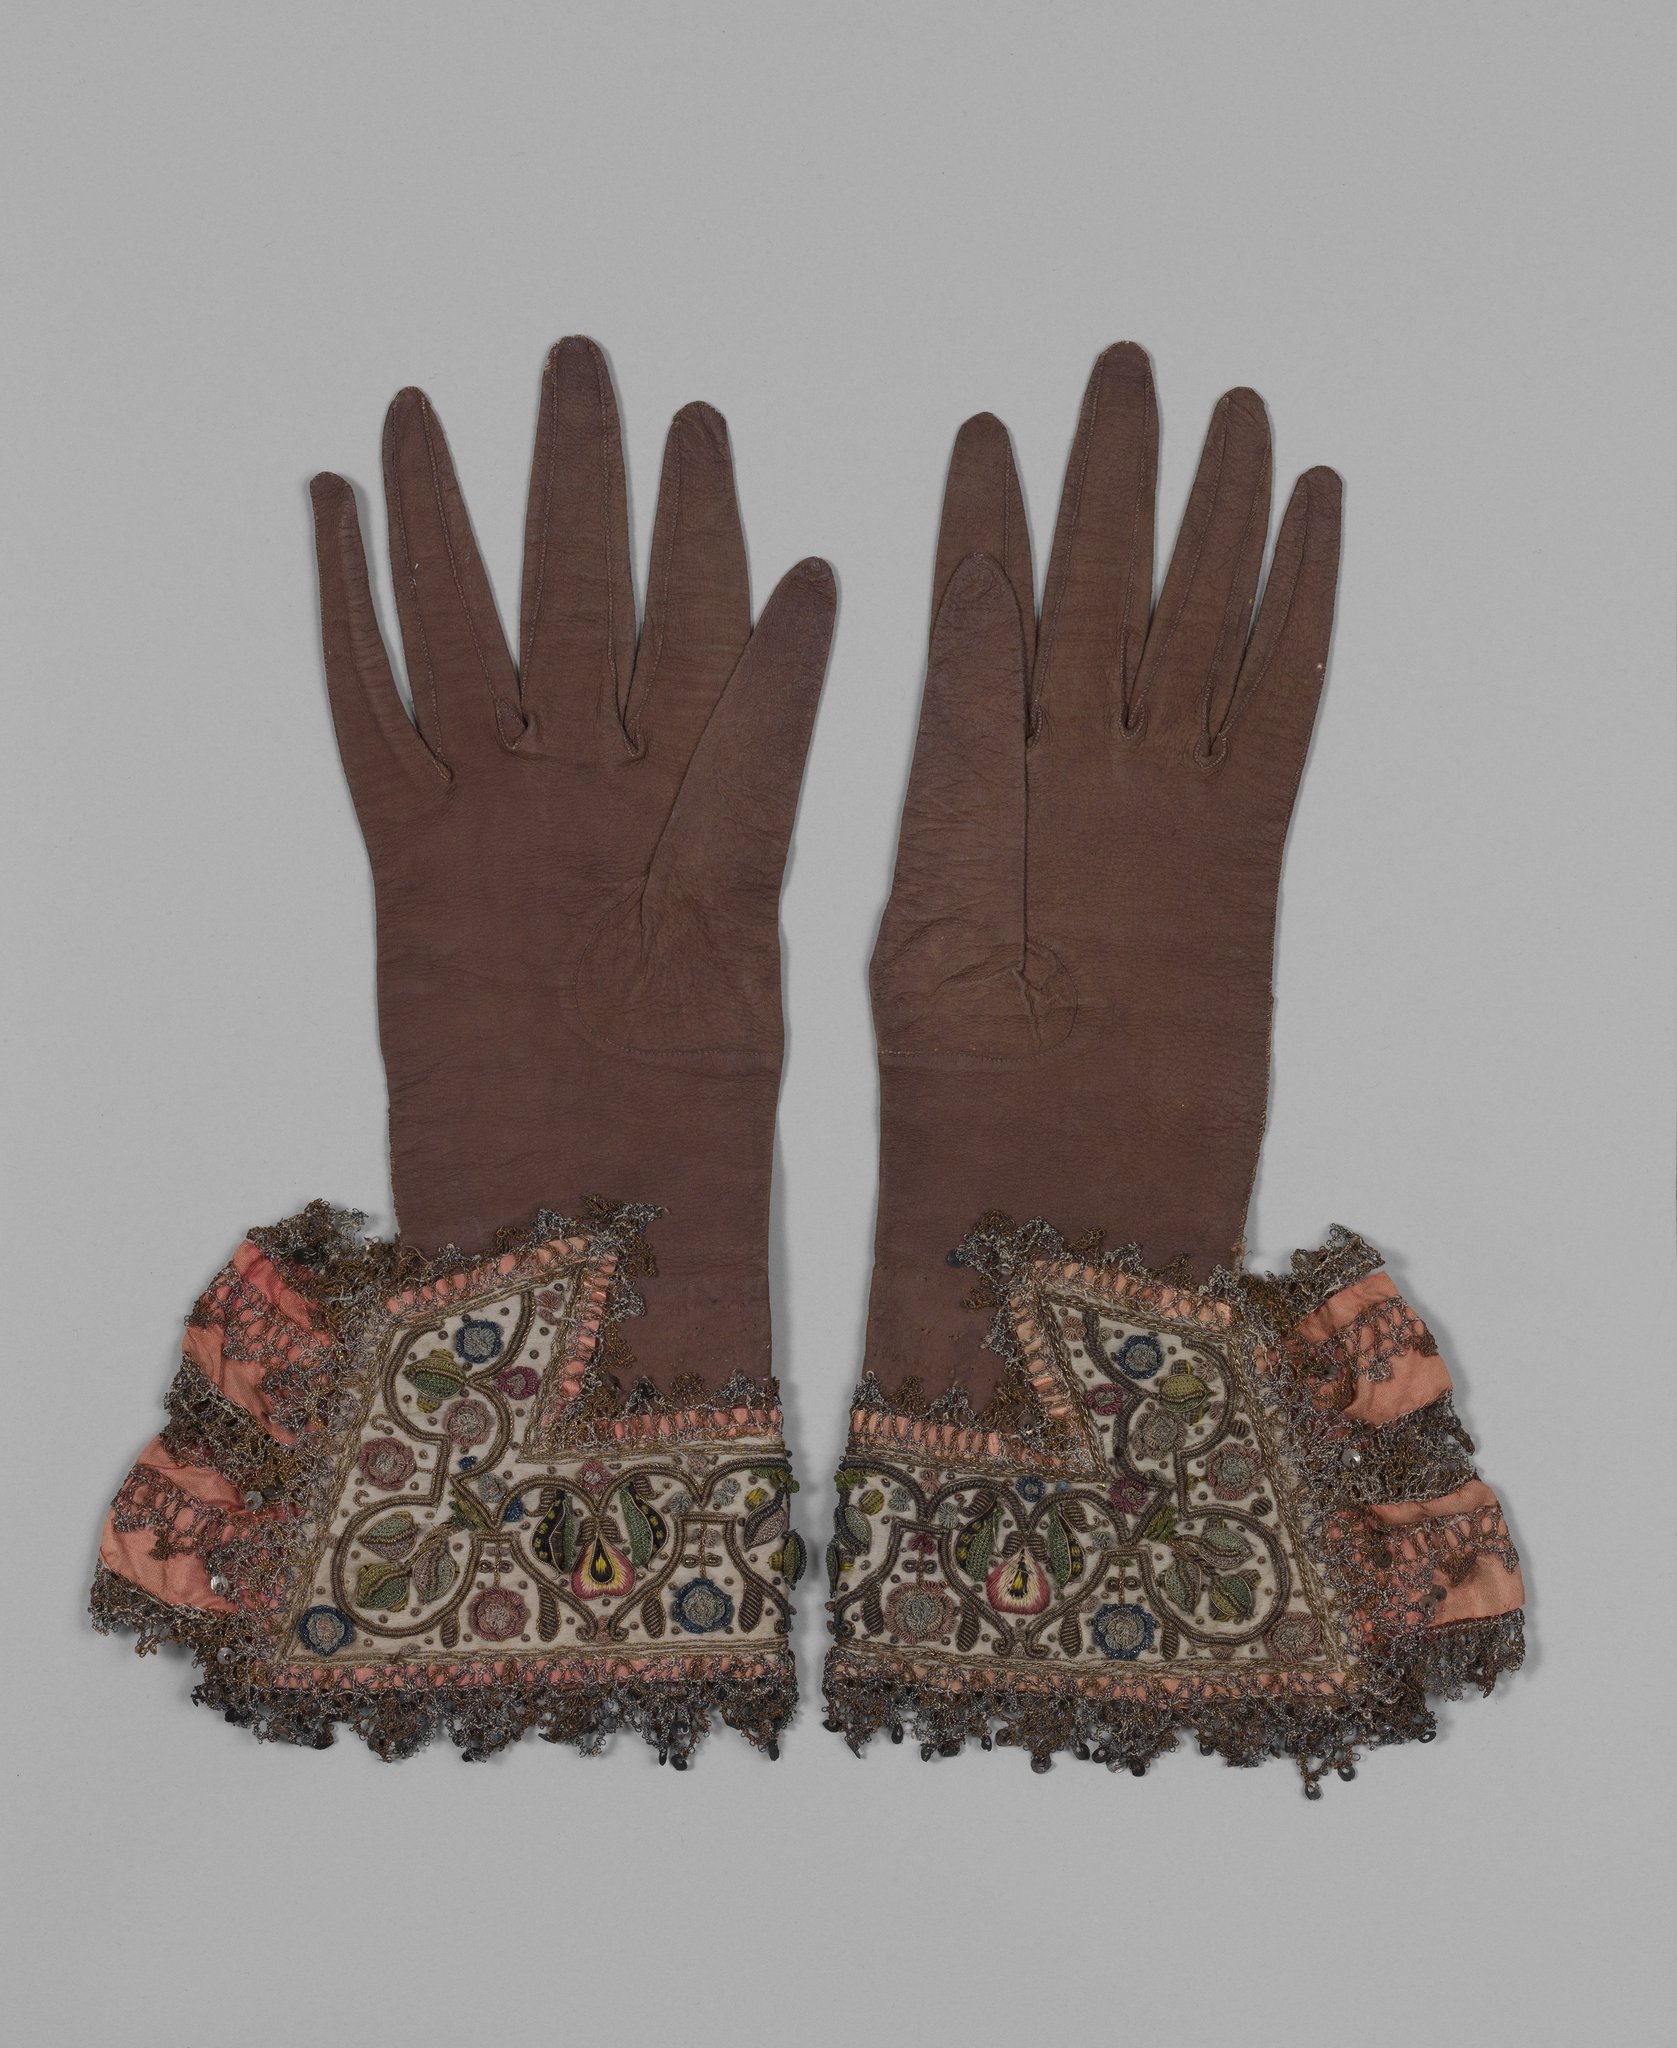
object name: glove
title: Pair of gloves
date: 1620-1629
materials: leather, metal, metal thread, ribbon, textile, silk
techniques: lace, embroidery, stitching